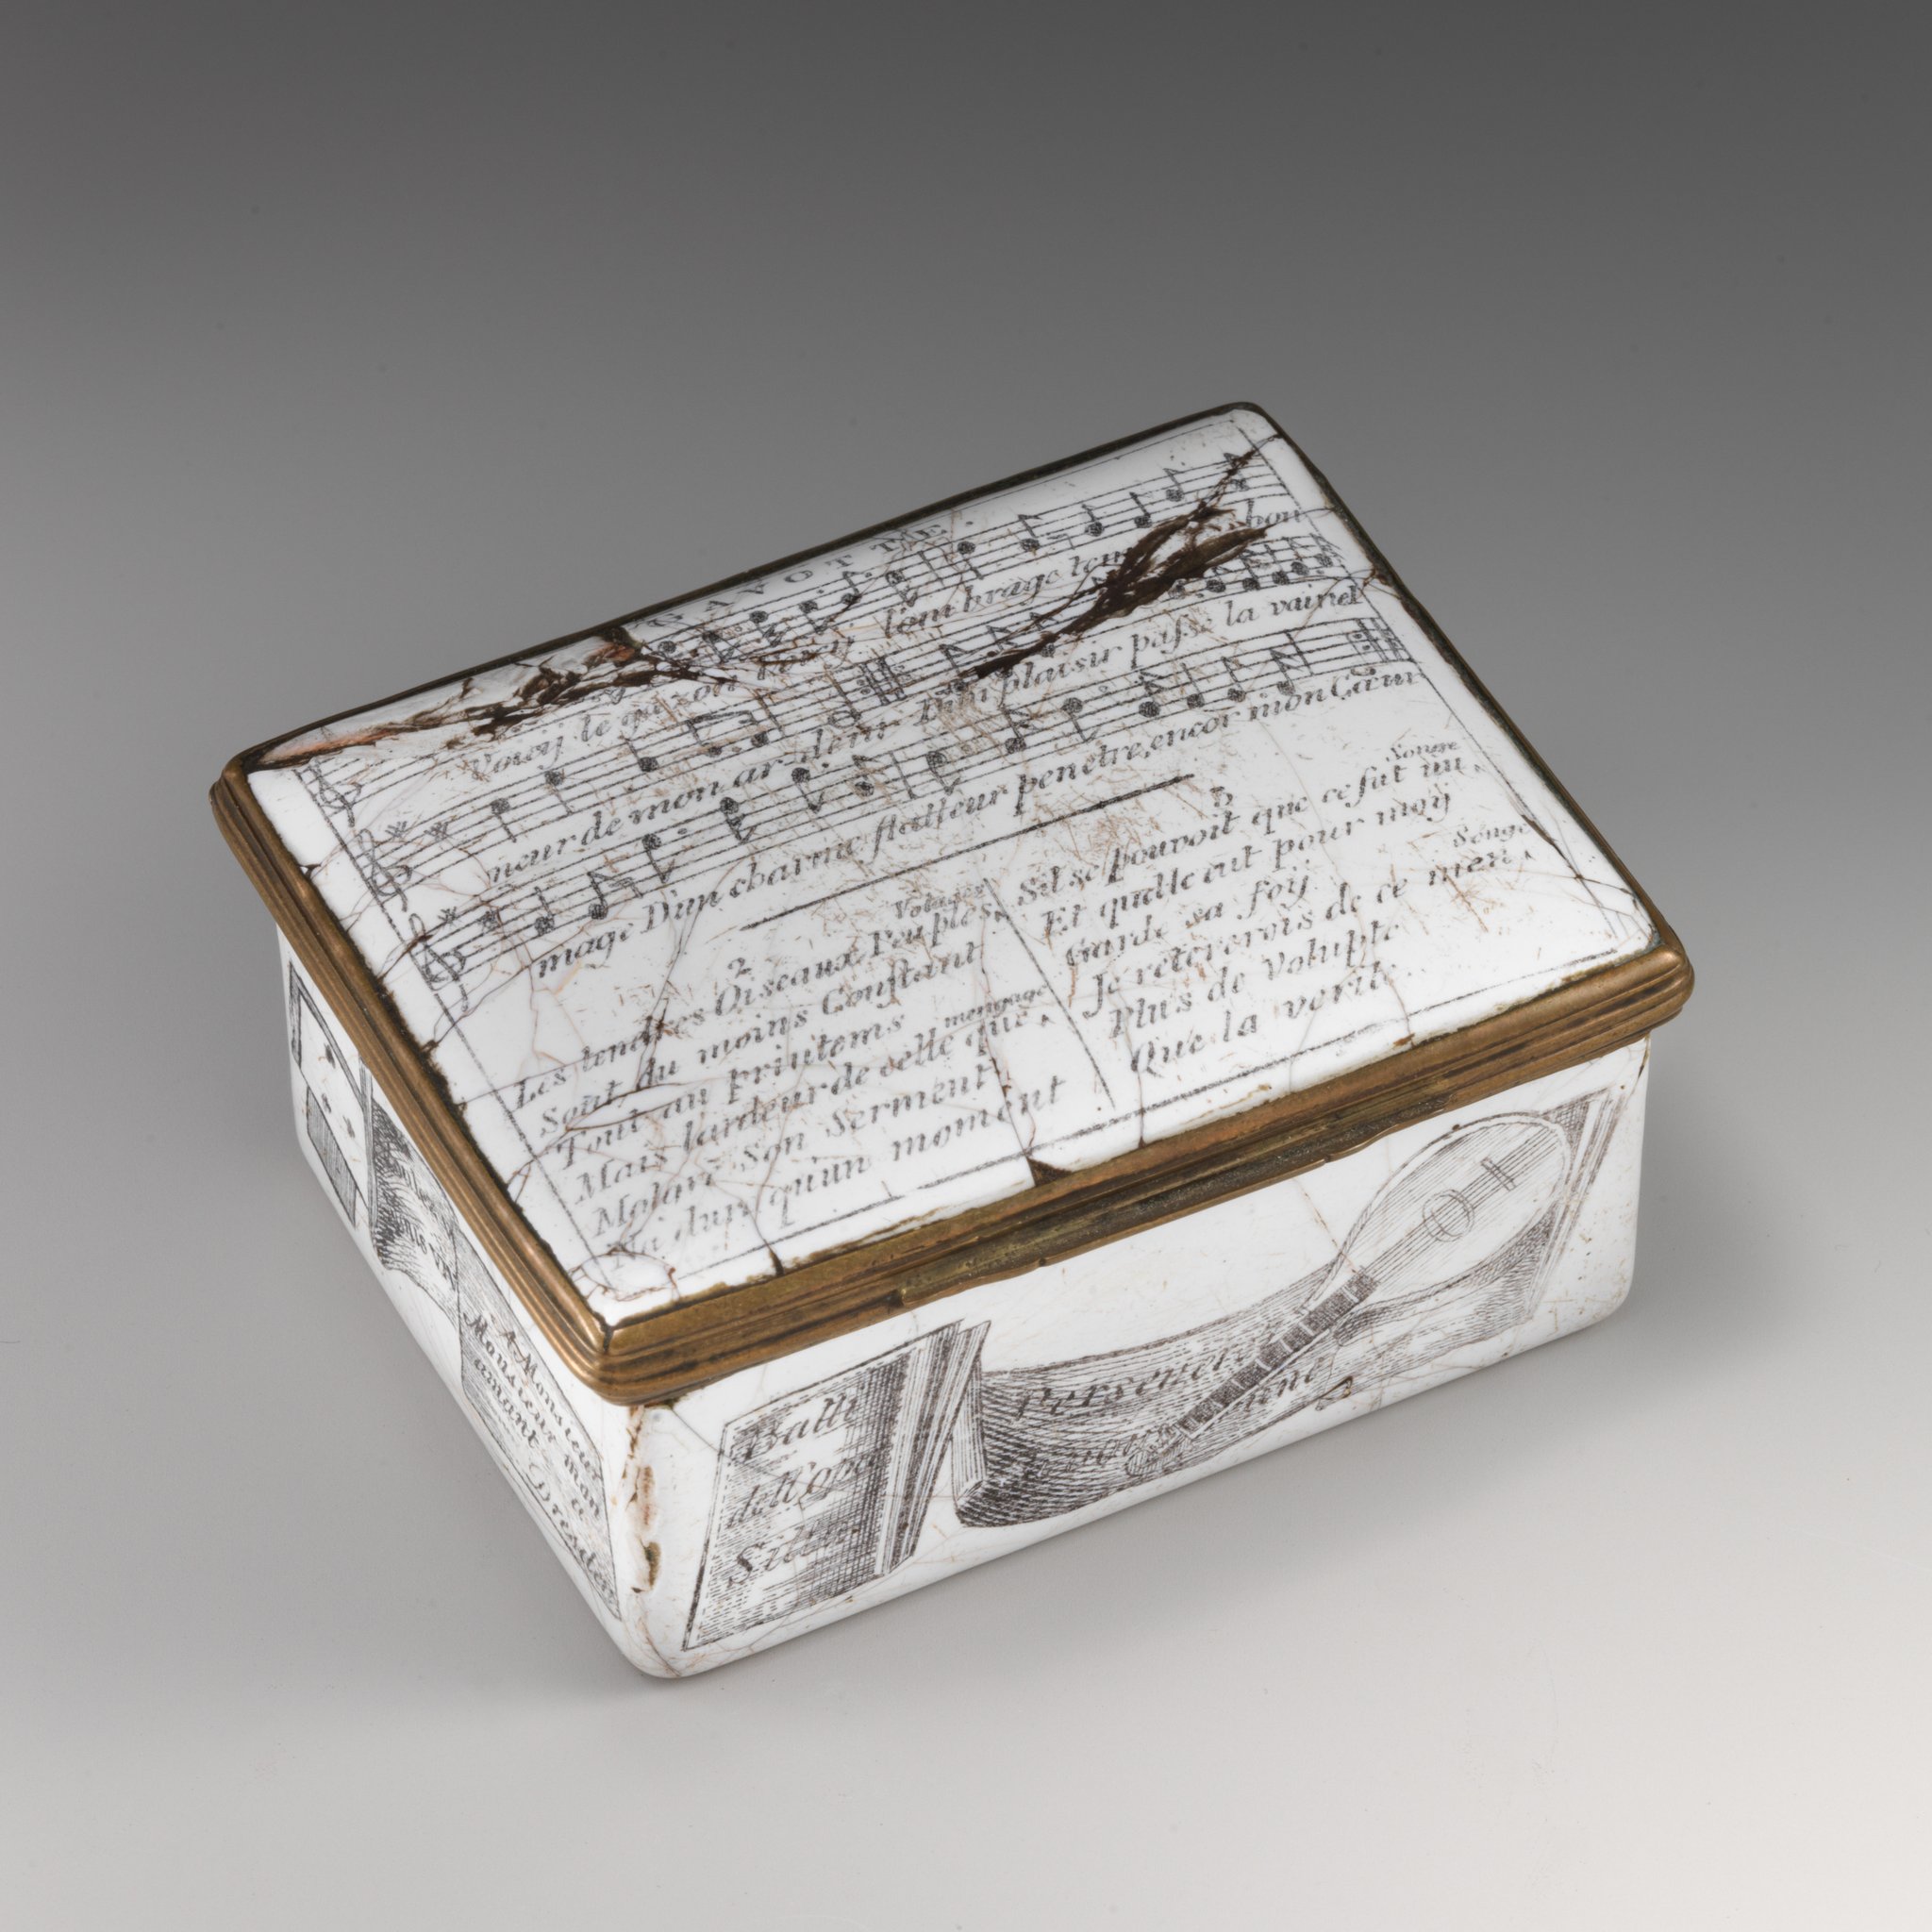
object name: snuffbox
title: Snuffbox with music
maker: anthony tregent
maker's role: enameler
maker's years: 1700-1800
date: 1760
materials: copper, enamel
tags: musical instruments,music